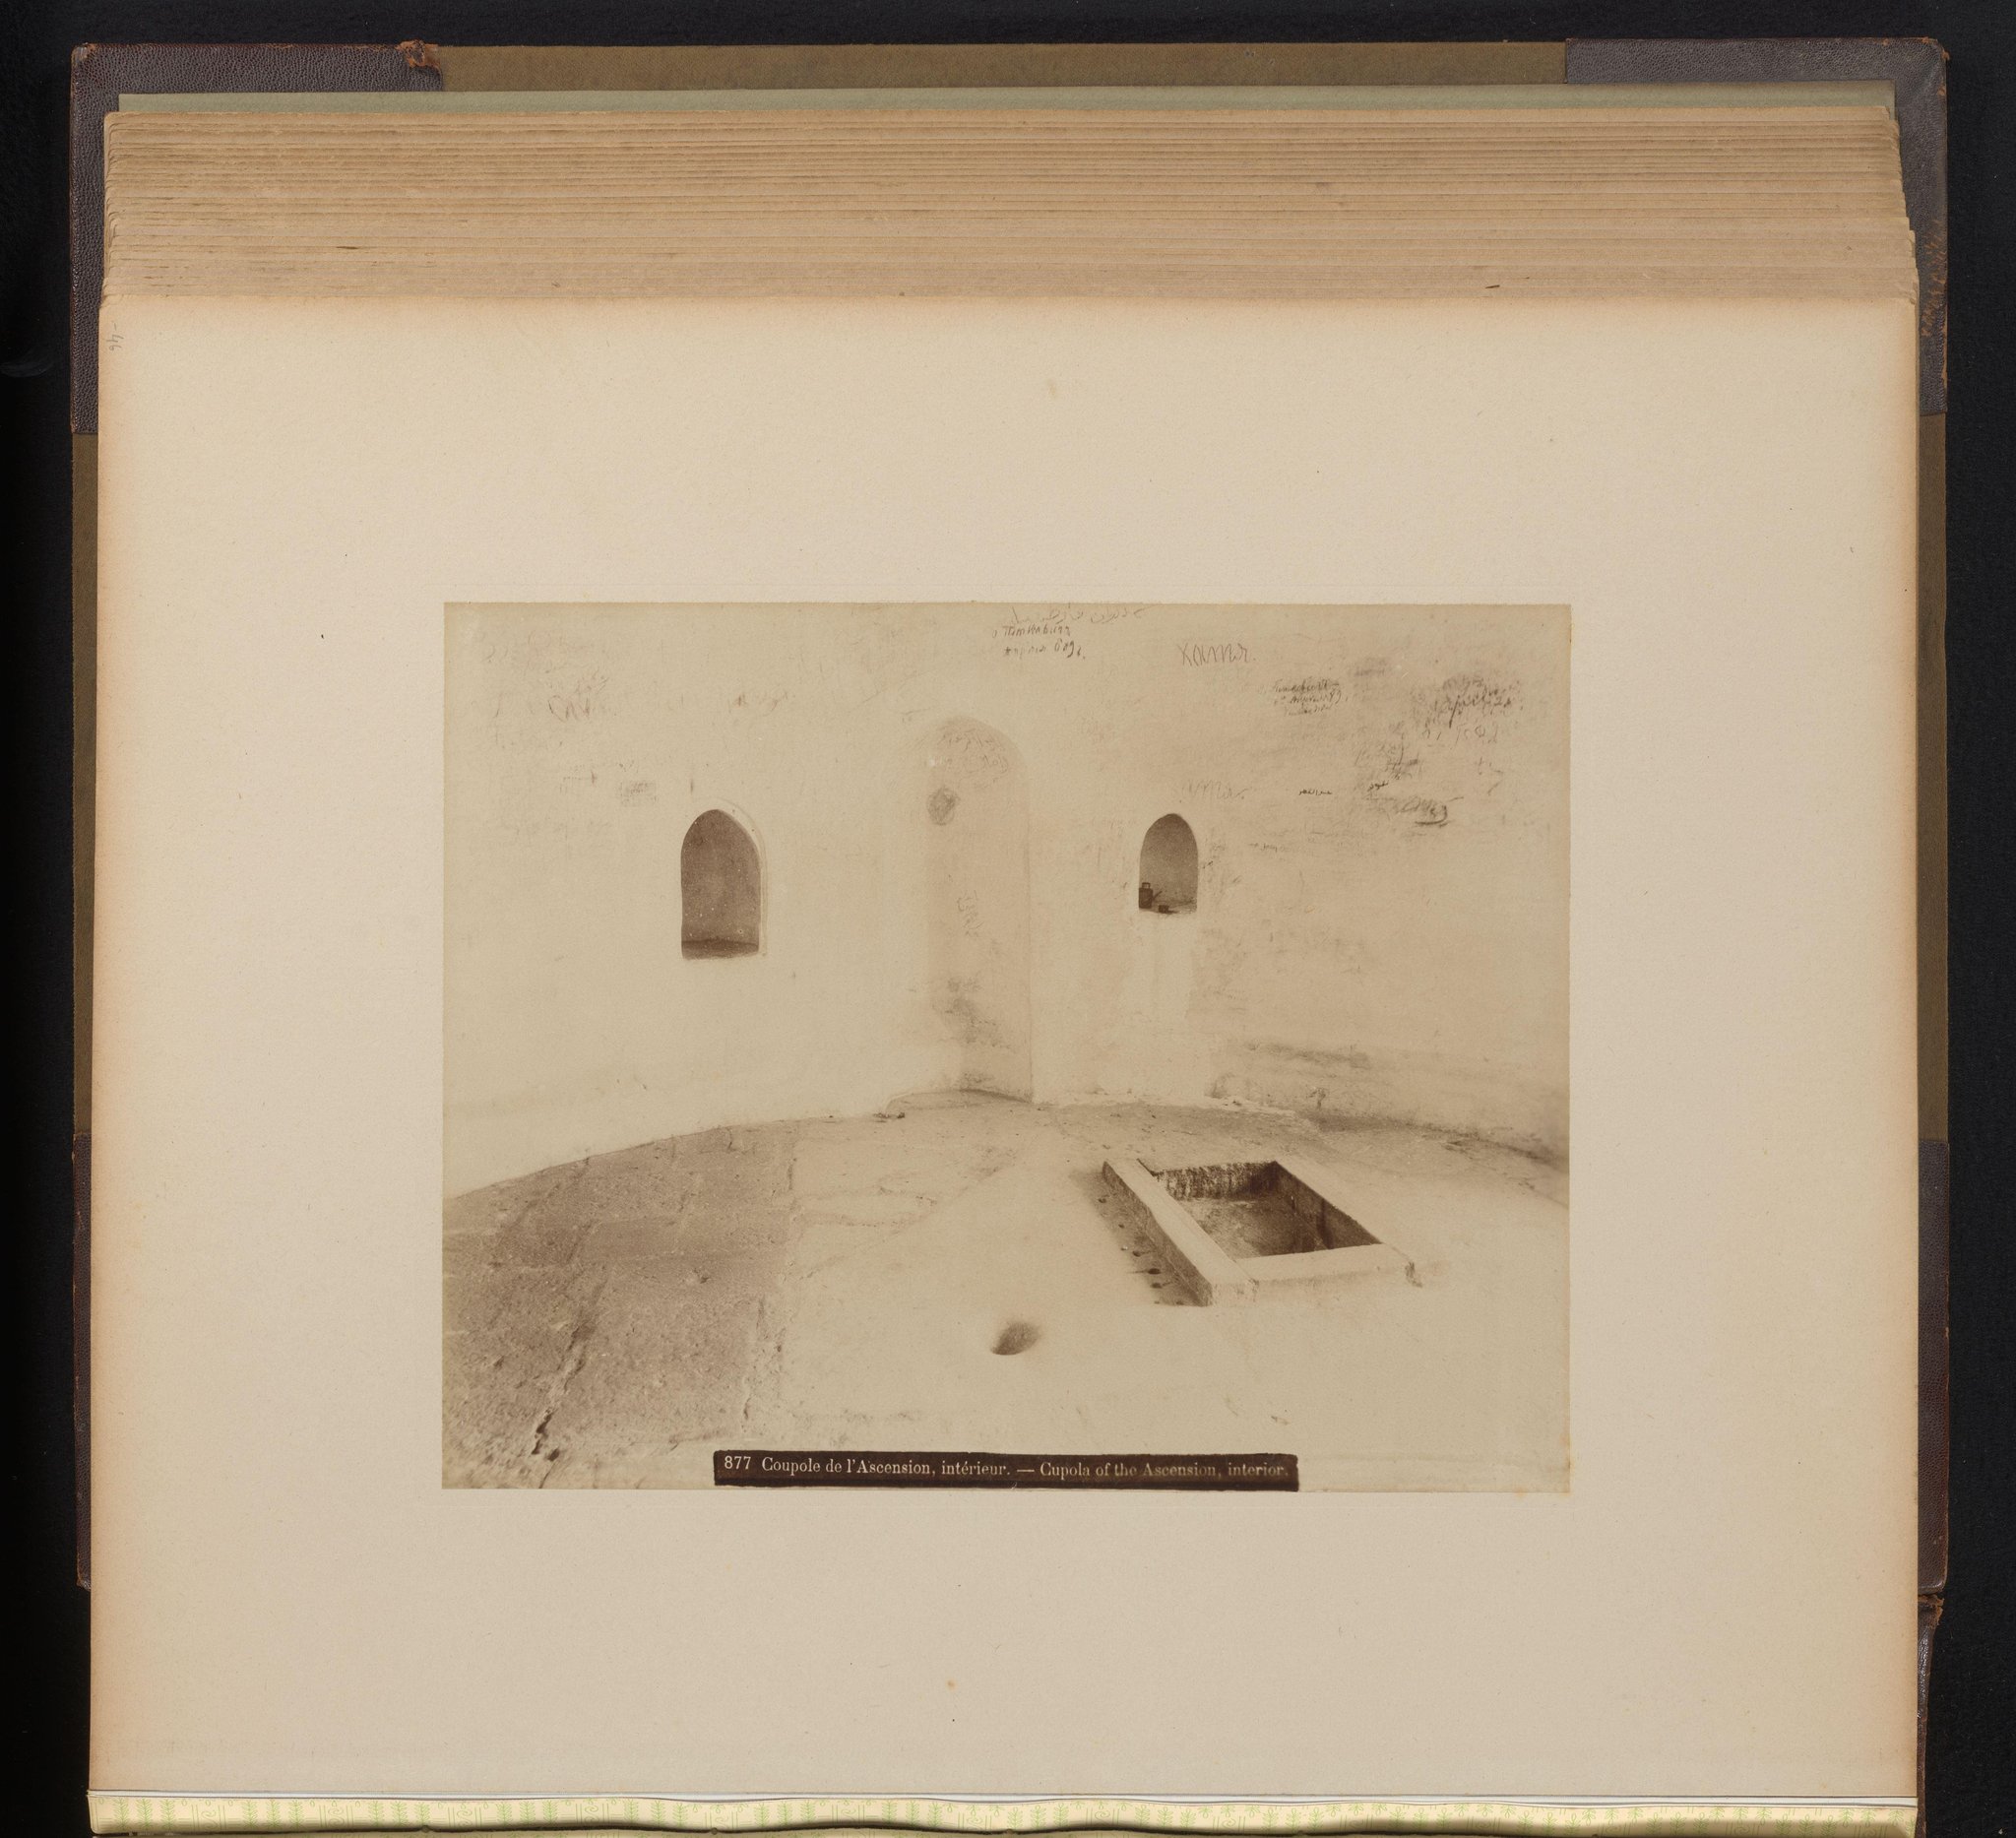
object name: photograph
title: Coupole de l'Ascension, intérieur / Cupola of the Ascension, interior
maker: félix bonfils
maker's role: fotograaf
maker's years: 1831-1885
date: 1867-1885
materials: paper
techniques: albumen print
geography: jerusalem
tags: interior of church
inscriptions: number: ‘877’